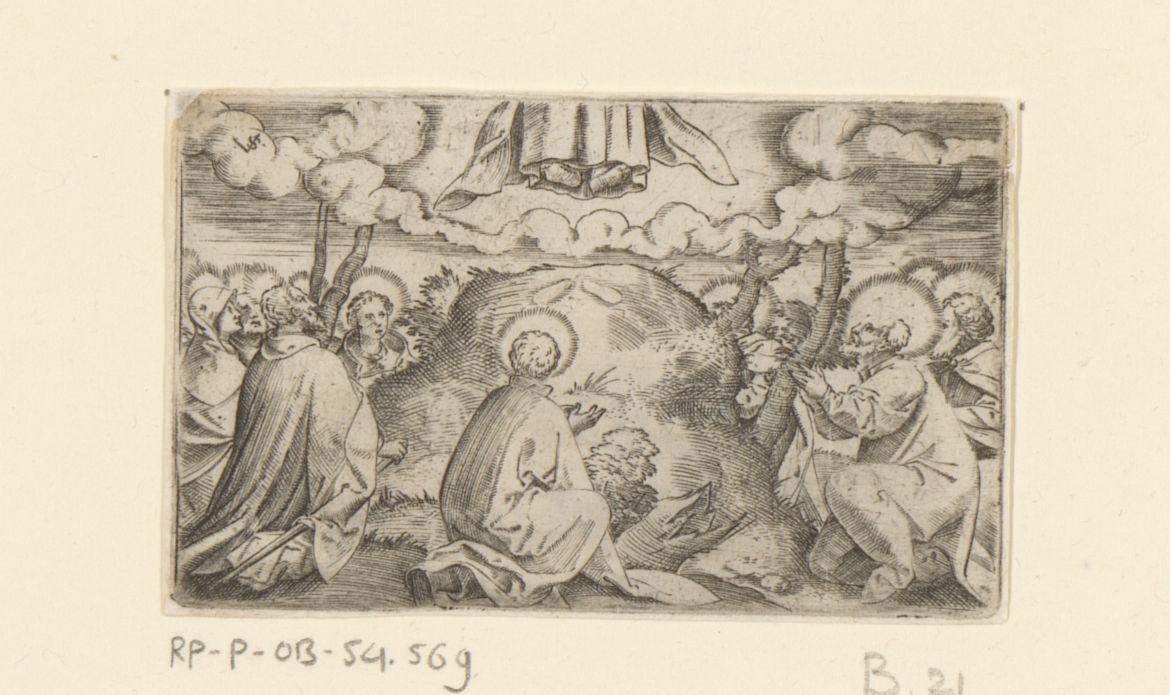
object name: print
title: Hemelvaart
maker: virgilius solis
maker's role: draughtsman, print maker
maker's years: 1514-1562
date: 1524-1562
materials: paper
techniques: engraving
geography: nuremberg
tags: christ ascends into heaven; apostles (and mary) beneath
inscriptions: collector's mark: Lugt 2228, number: ‘82’